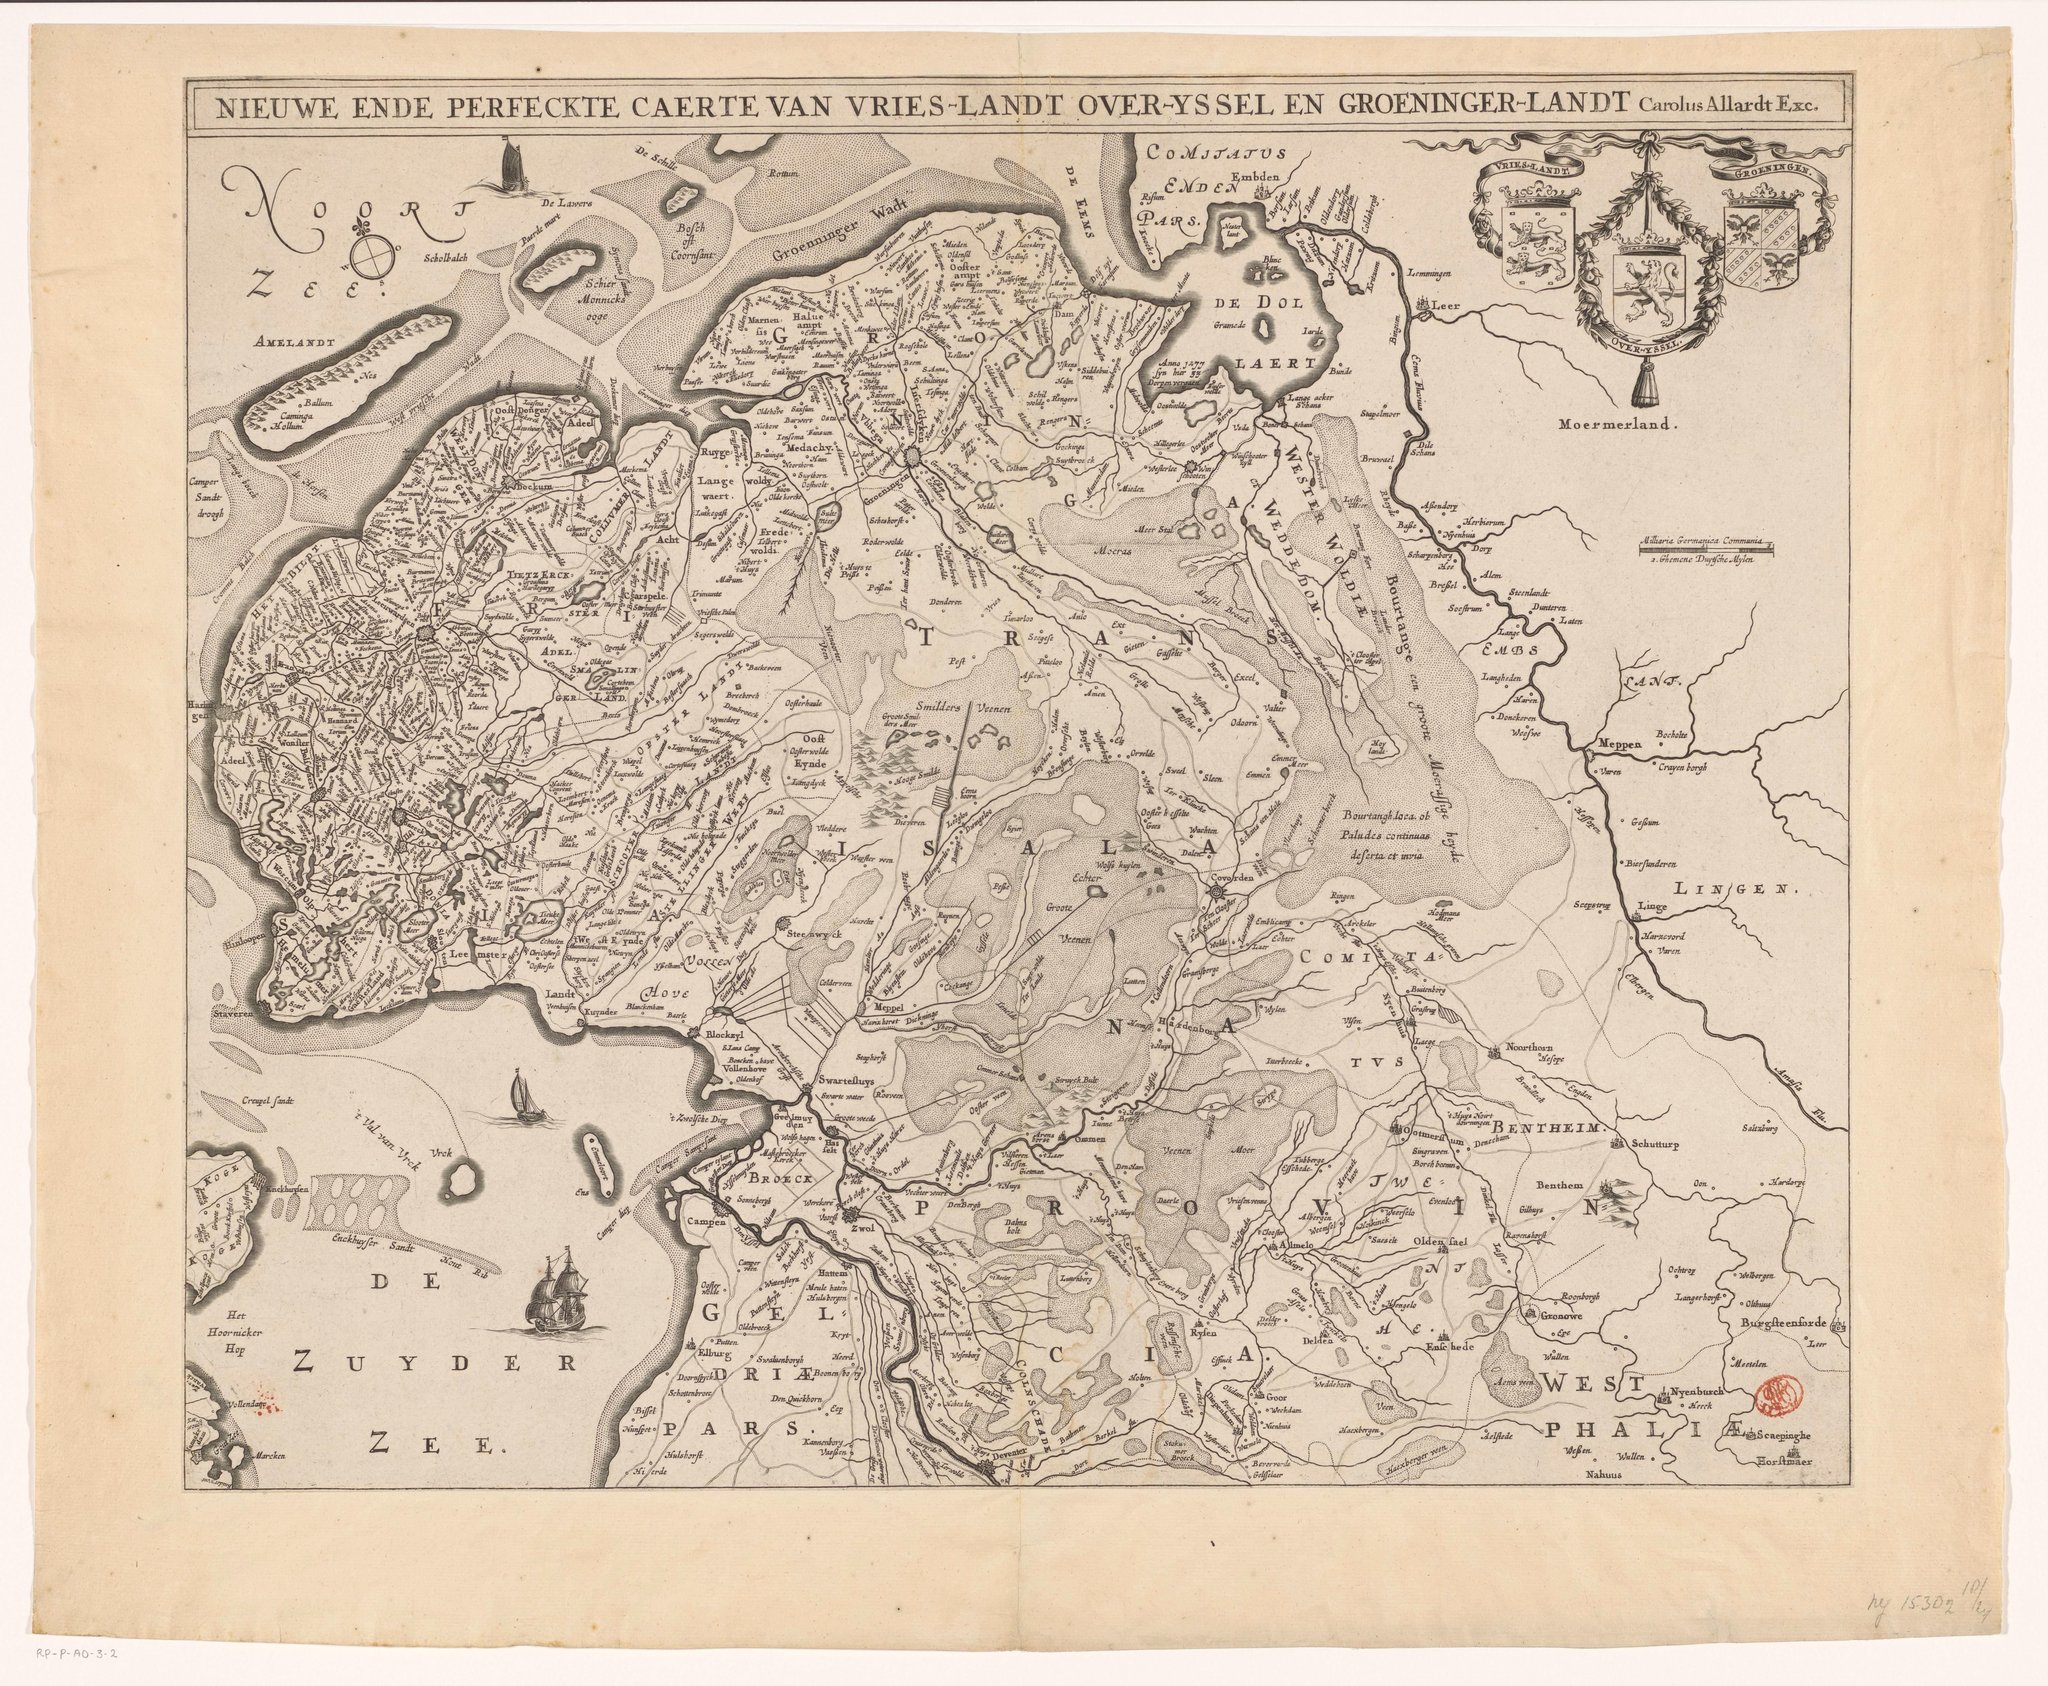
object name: print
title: Kaart van Friesland, Overijssel en Groningen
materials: paper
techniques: engraving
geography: amsterdam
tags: coat of arms (as symbol of the state, etc.), maps of separate countries or regions, groningen (province)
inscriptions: collector's mark: Lugt 195, collector's mark: Lugt 2228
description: Rechtsboven de wapens van Friesland, Overijssel en Groningen. Daaronder een schaalstok: Milliaria Germanica communia / Ghemene Dutsche mylen.